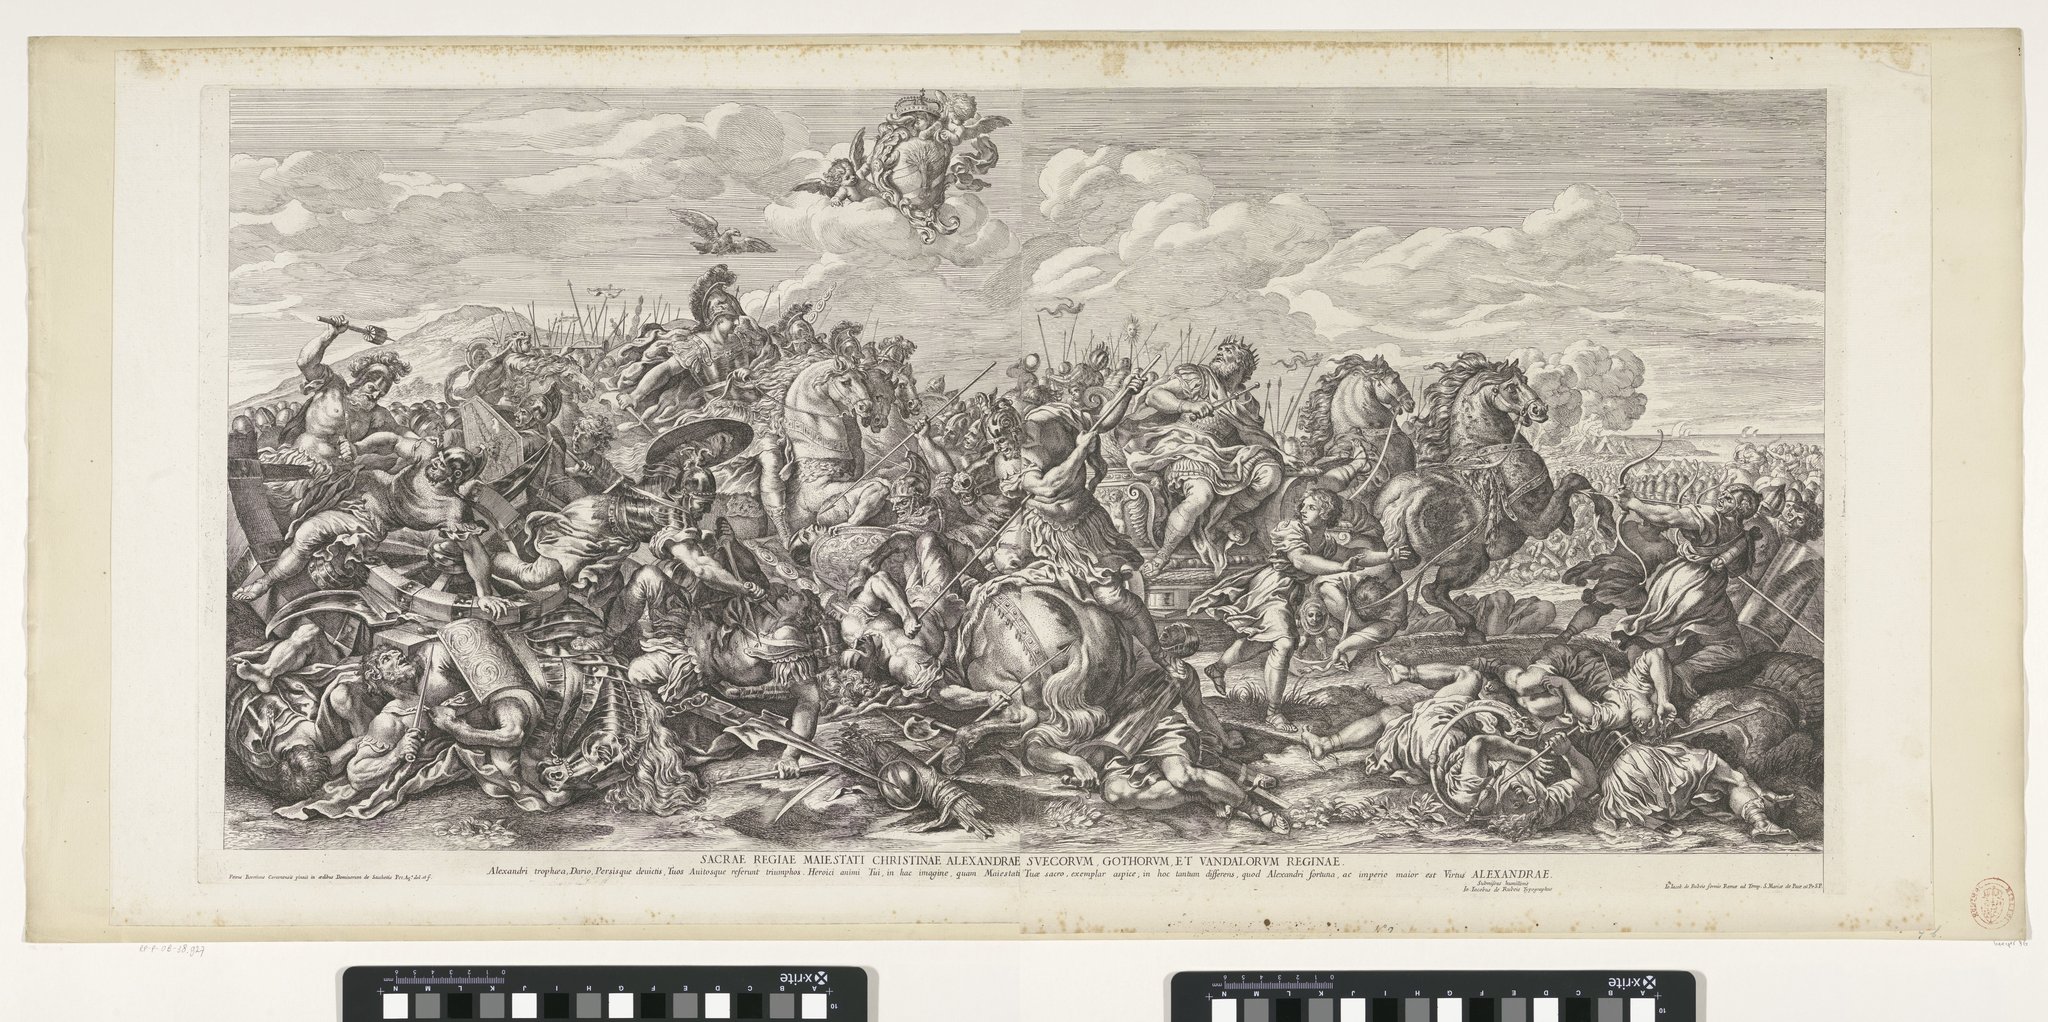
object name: print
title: Slag bij Arbella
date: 1660-1692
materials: paper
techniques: etching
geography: vatican city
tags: battle, (story of) alexander the great, warfare; military affairs (+ cavalry, horsemen), the soldier; the soldier's life, fighting, (story of) darius, king of persia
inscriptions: collector's mark: Lugt 240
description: De slag tussen de legers van Alexander de Grote en Darius bij Arbella.